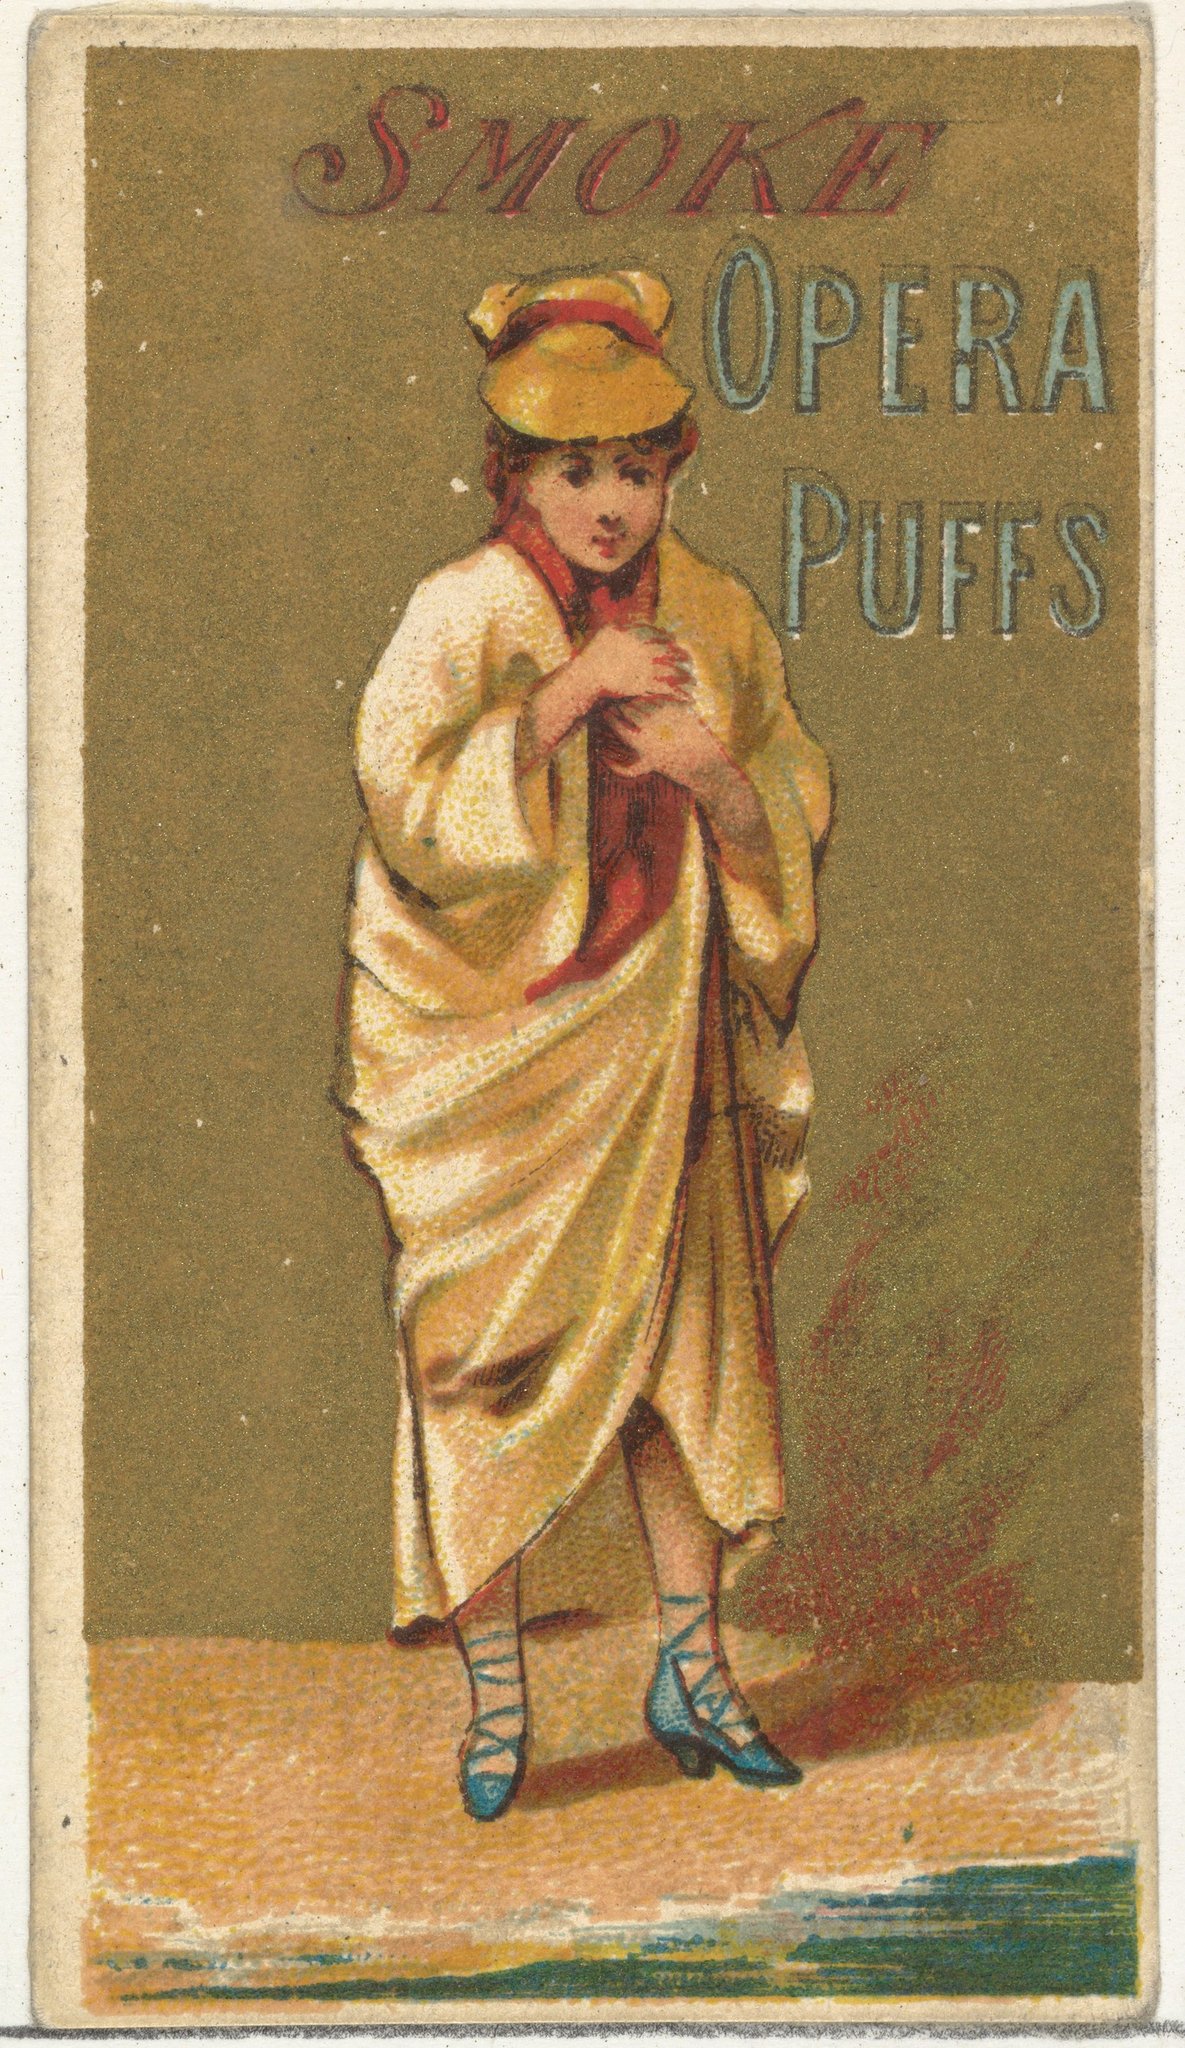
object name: print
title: From the Girls and Children series (N65) promoting Opera Puffs Cigarettes for Allen & Ginter brand tobacco products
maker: allen & ginter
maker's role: publisher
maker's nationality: american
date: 1886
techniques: color lithograph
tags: girls